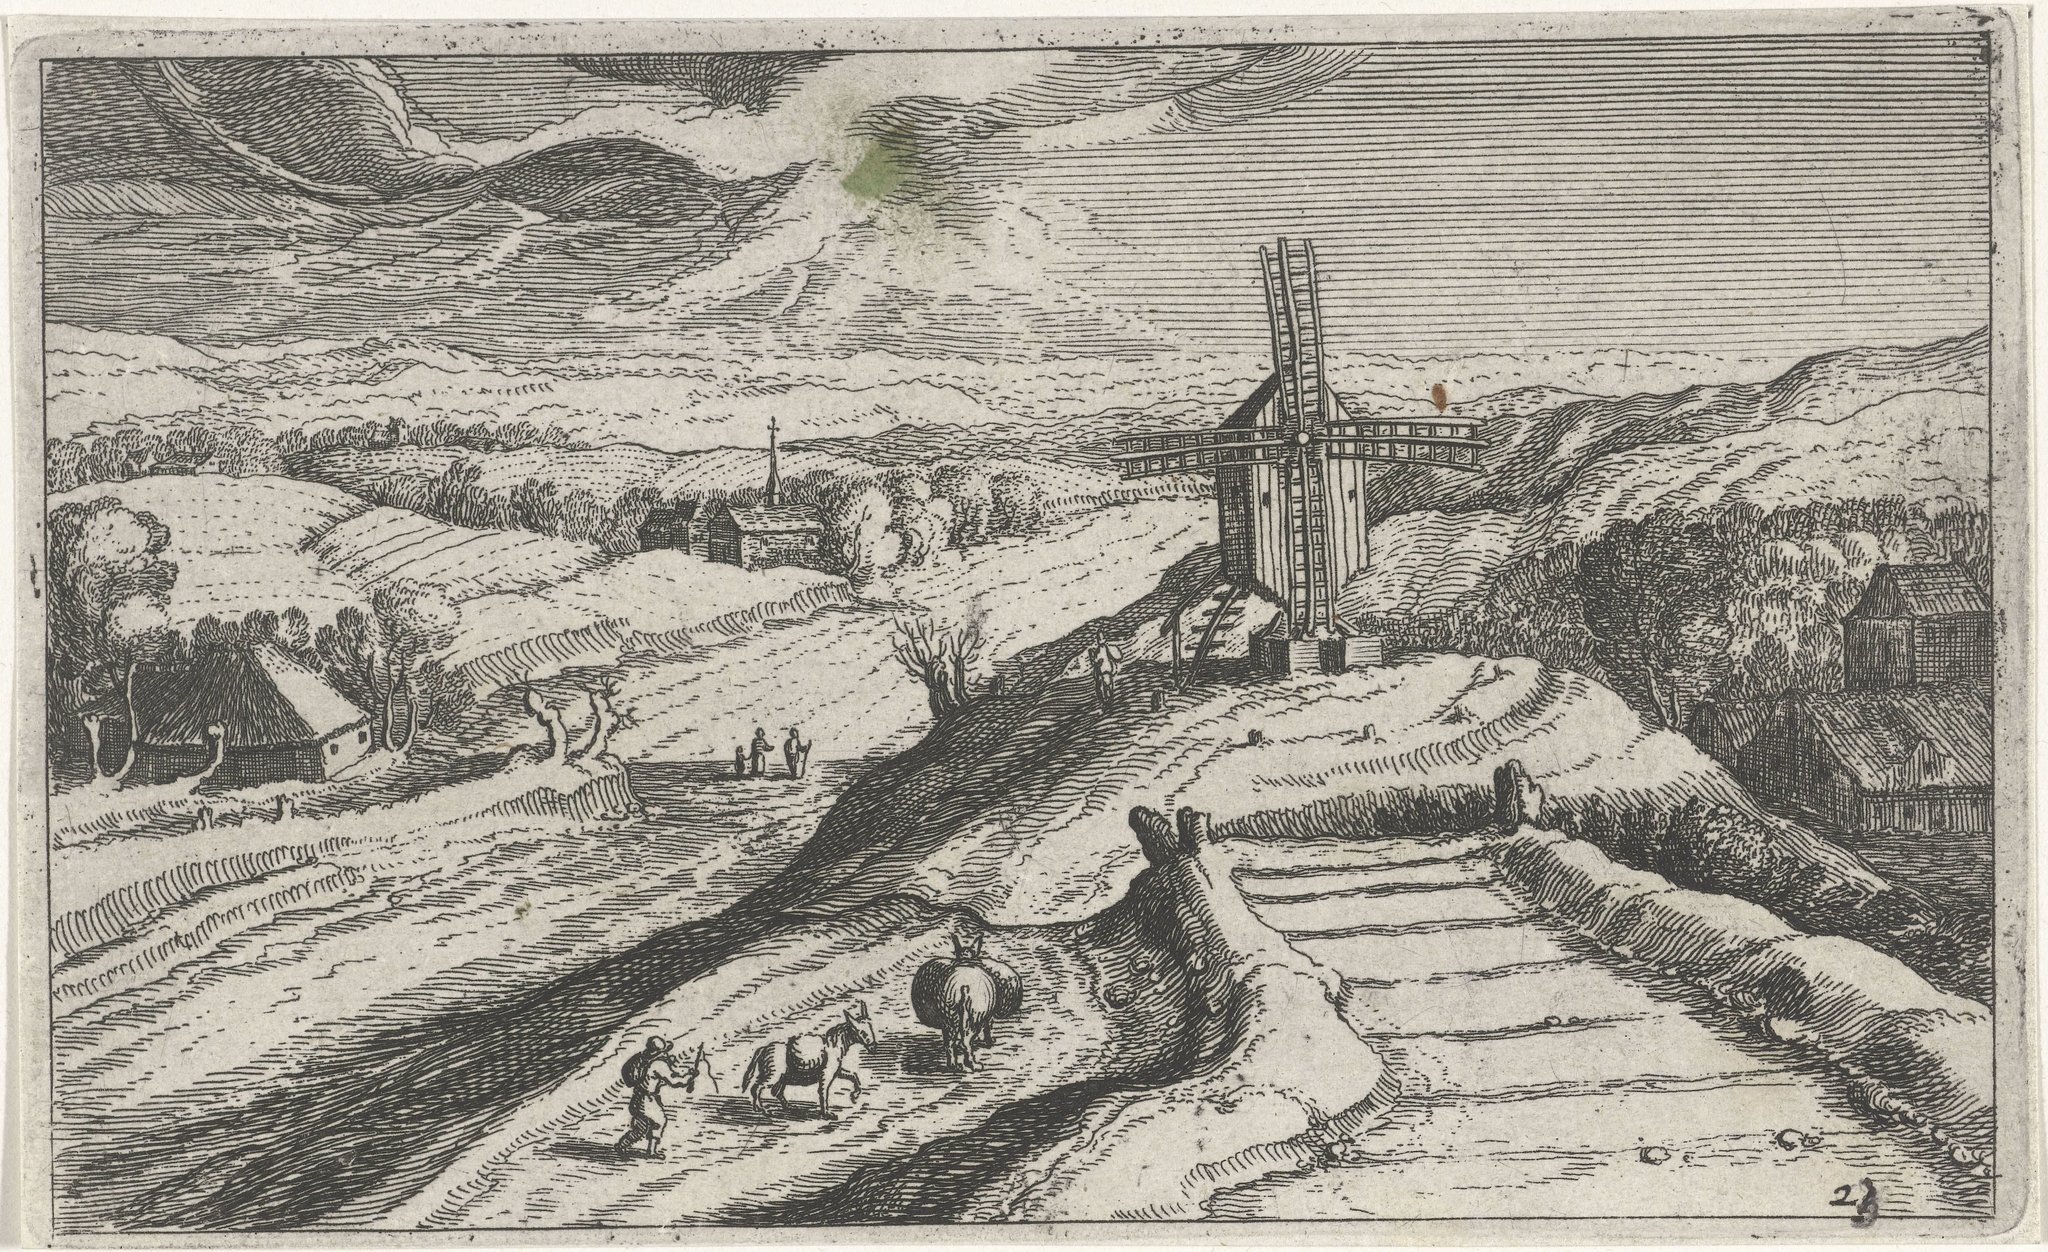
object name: print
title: Verschillende landschappen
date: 1614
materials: paper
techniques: etching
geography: the hague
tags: windmill in landscape (+ city(-scape) with figures, staffage)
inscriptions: collector's mark: Lugt 2228, number: ‘5’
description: Heuvellandschap met een windmolen. Op de voorgrond een man met twee bepakte ezels.